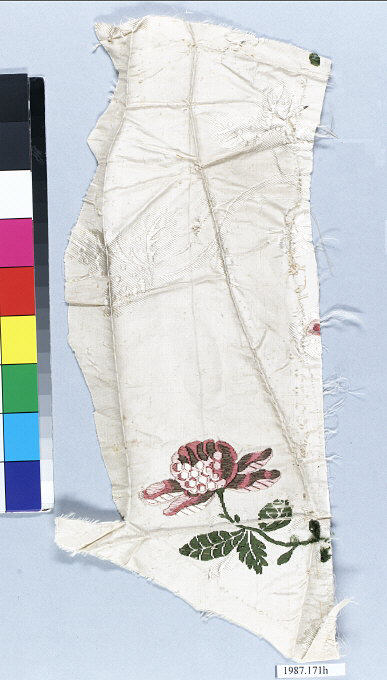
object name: piece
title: Piece (?)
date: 1750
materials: silk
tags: flowers,leaves